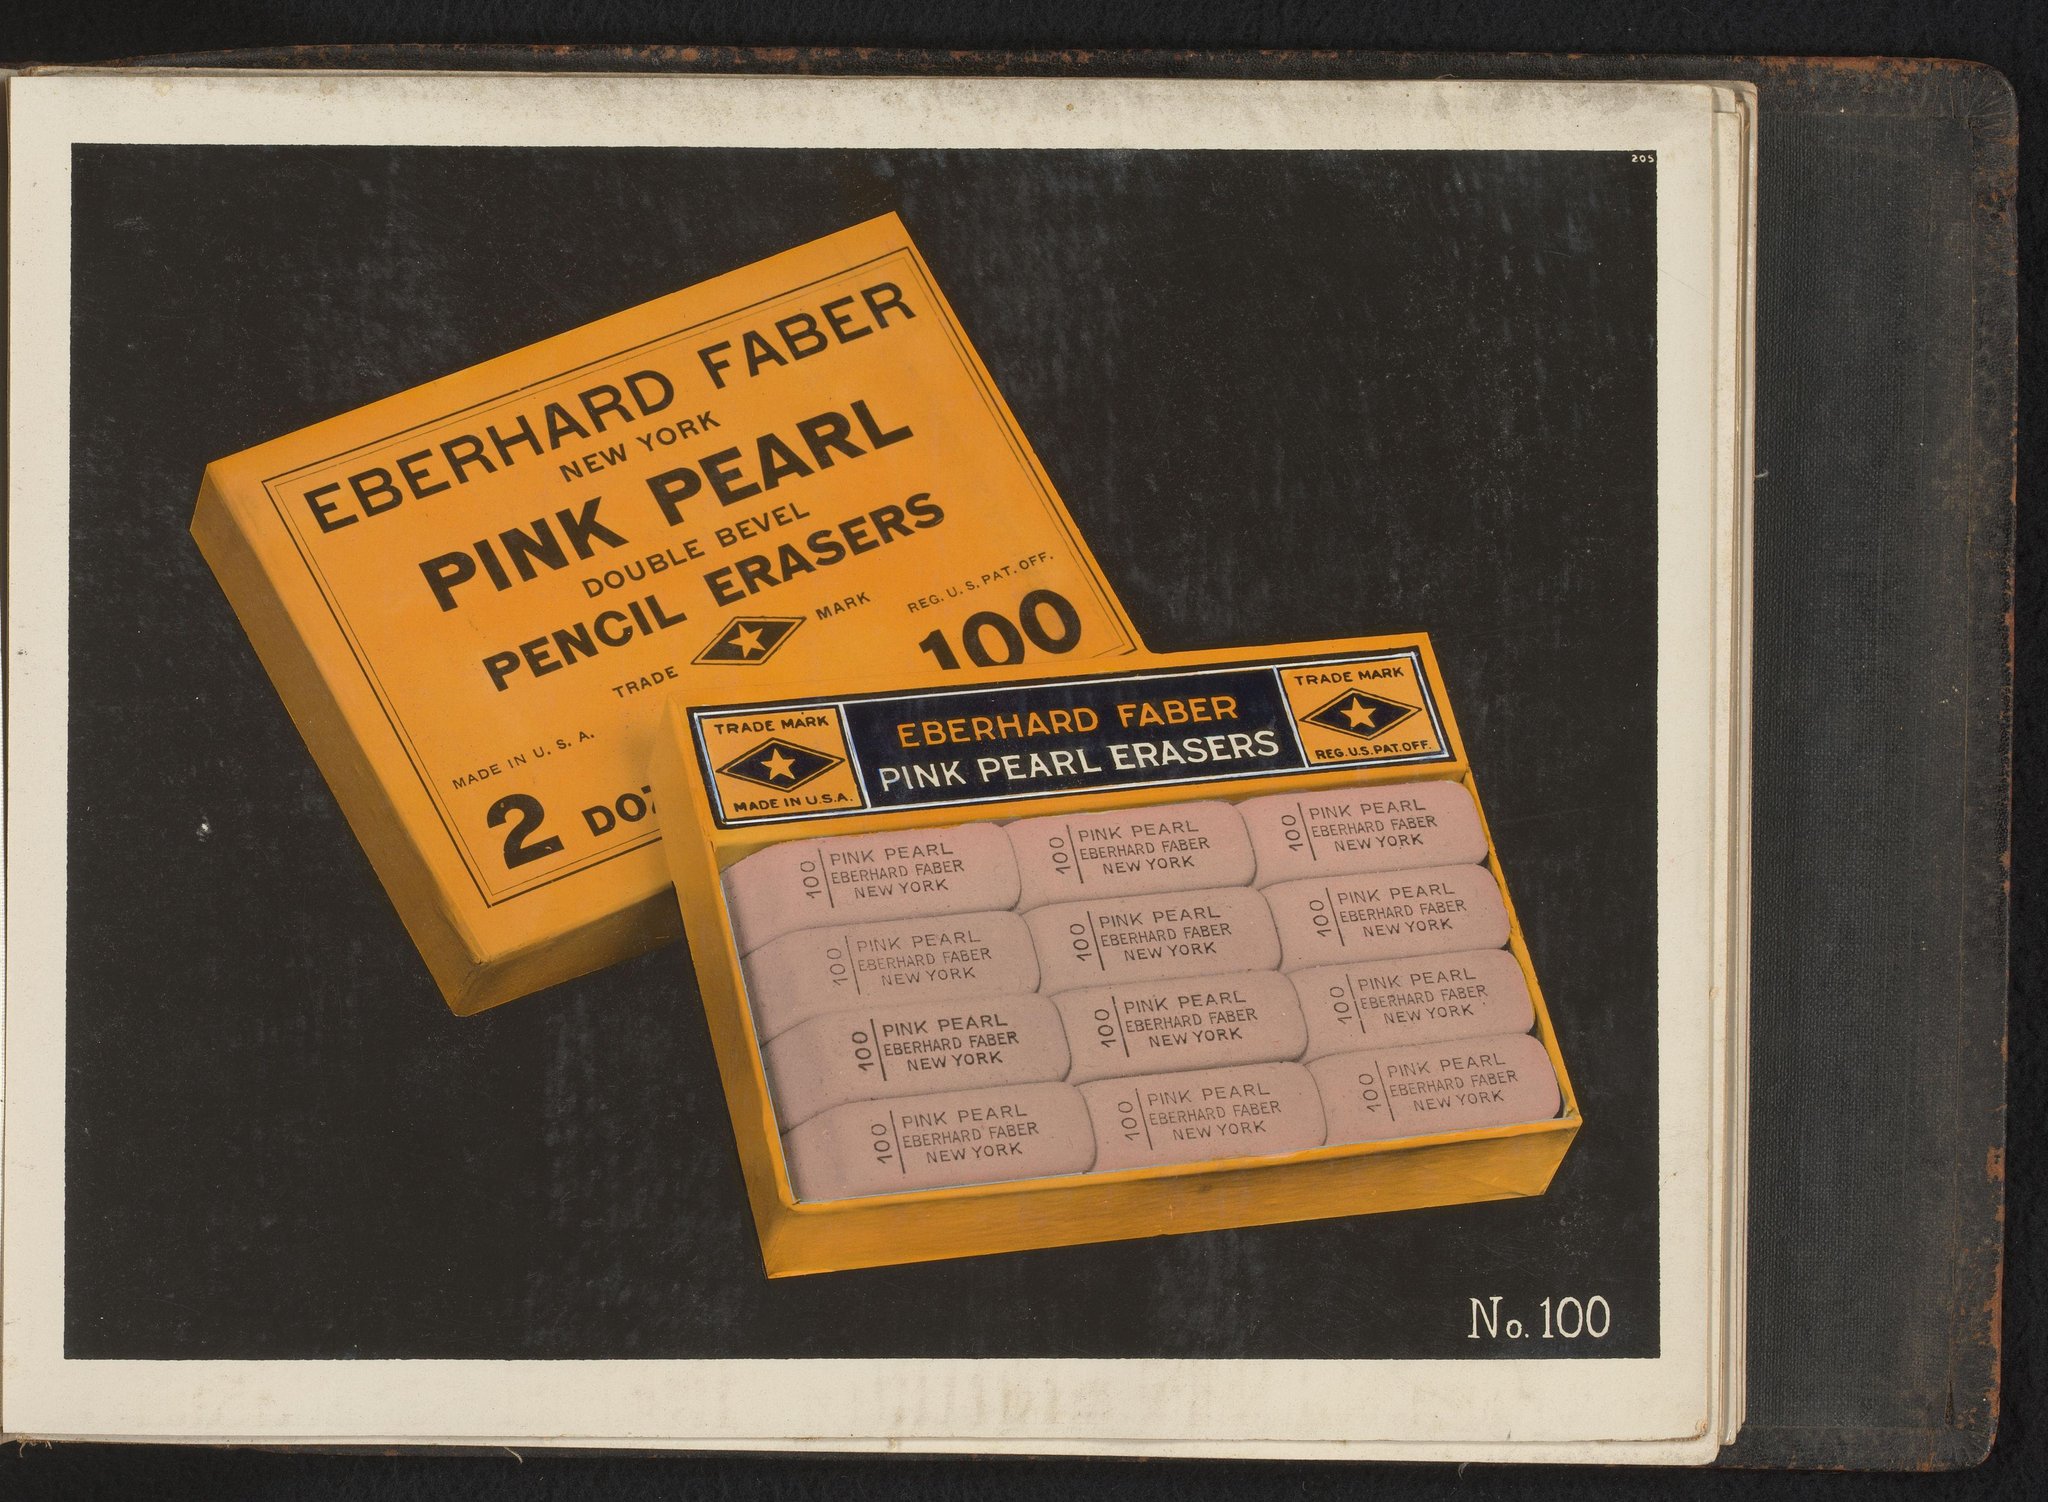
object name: photograph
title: Doos met gummen van Eberhard Faber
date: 1915-1935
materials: paper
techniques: gelatin silver print, hand coloring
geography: springfield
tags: writing tools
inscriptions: stamp: ‘Paramount/ Commercial Studios/ 145 Chestnut St./ Springfield - Mass.’, number: ‘205’